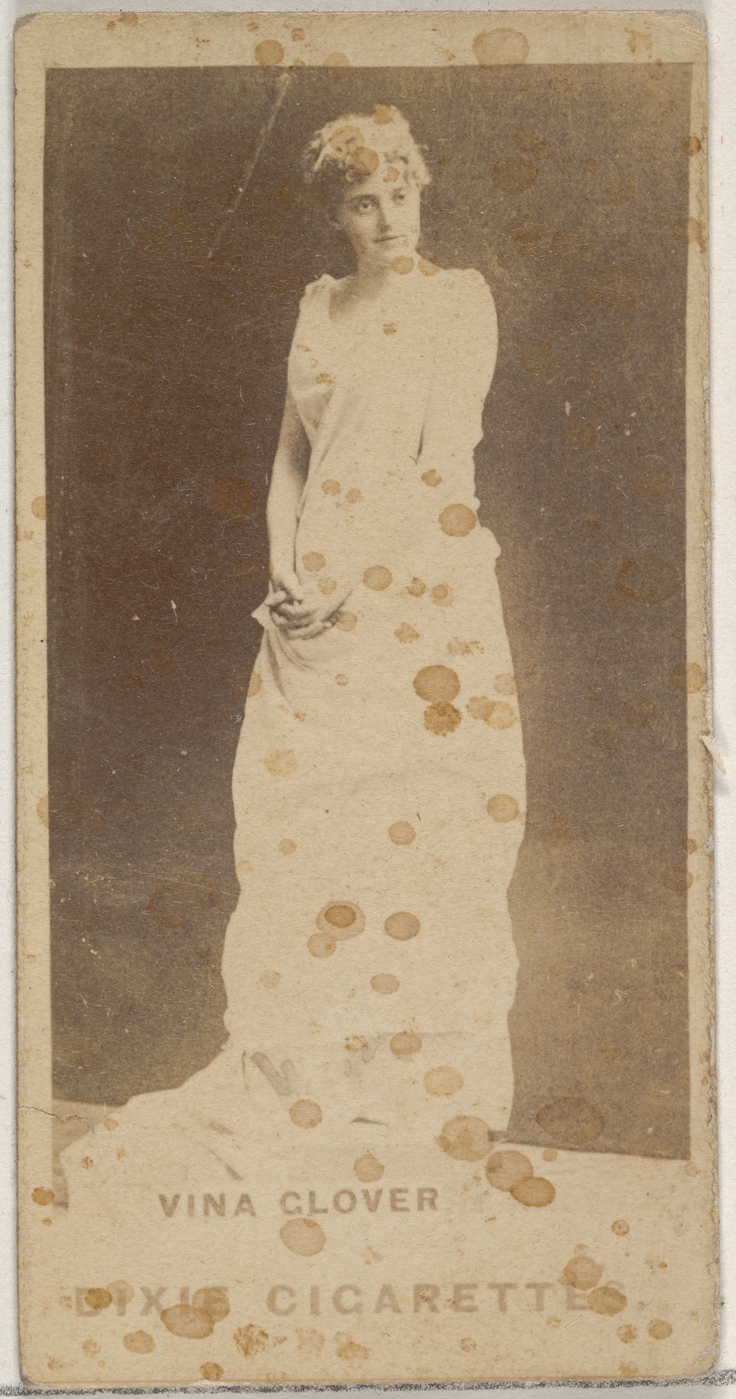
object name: photograph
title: Vina Glover, from the Actors and Actresses series (N45, Type 7) for Dixie Cigarettes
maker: allen & ginter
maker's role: publisher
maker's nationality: american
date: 1888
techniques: albumen silver print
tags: portraits,women,actresses